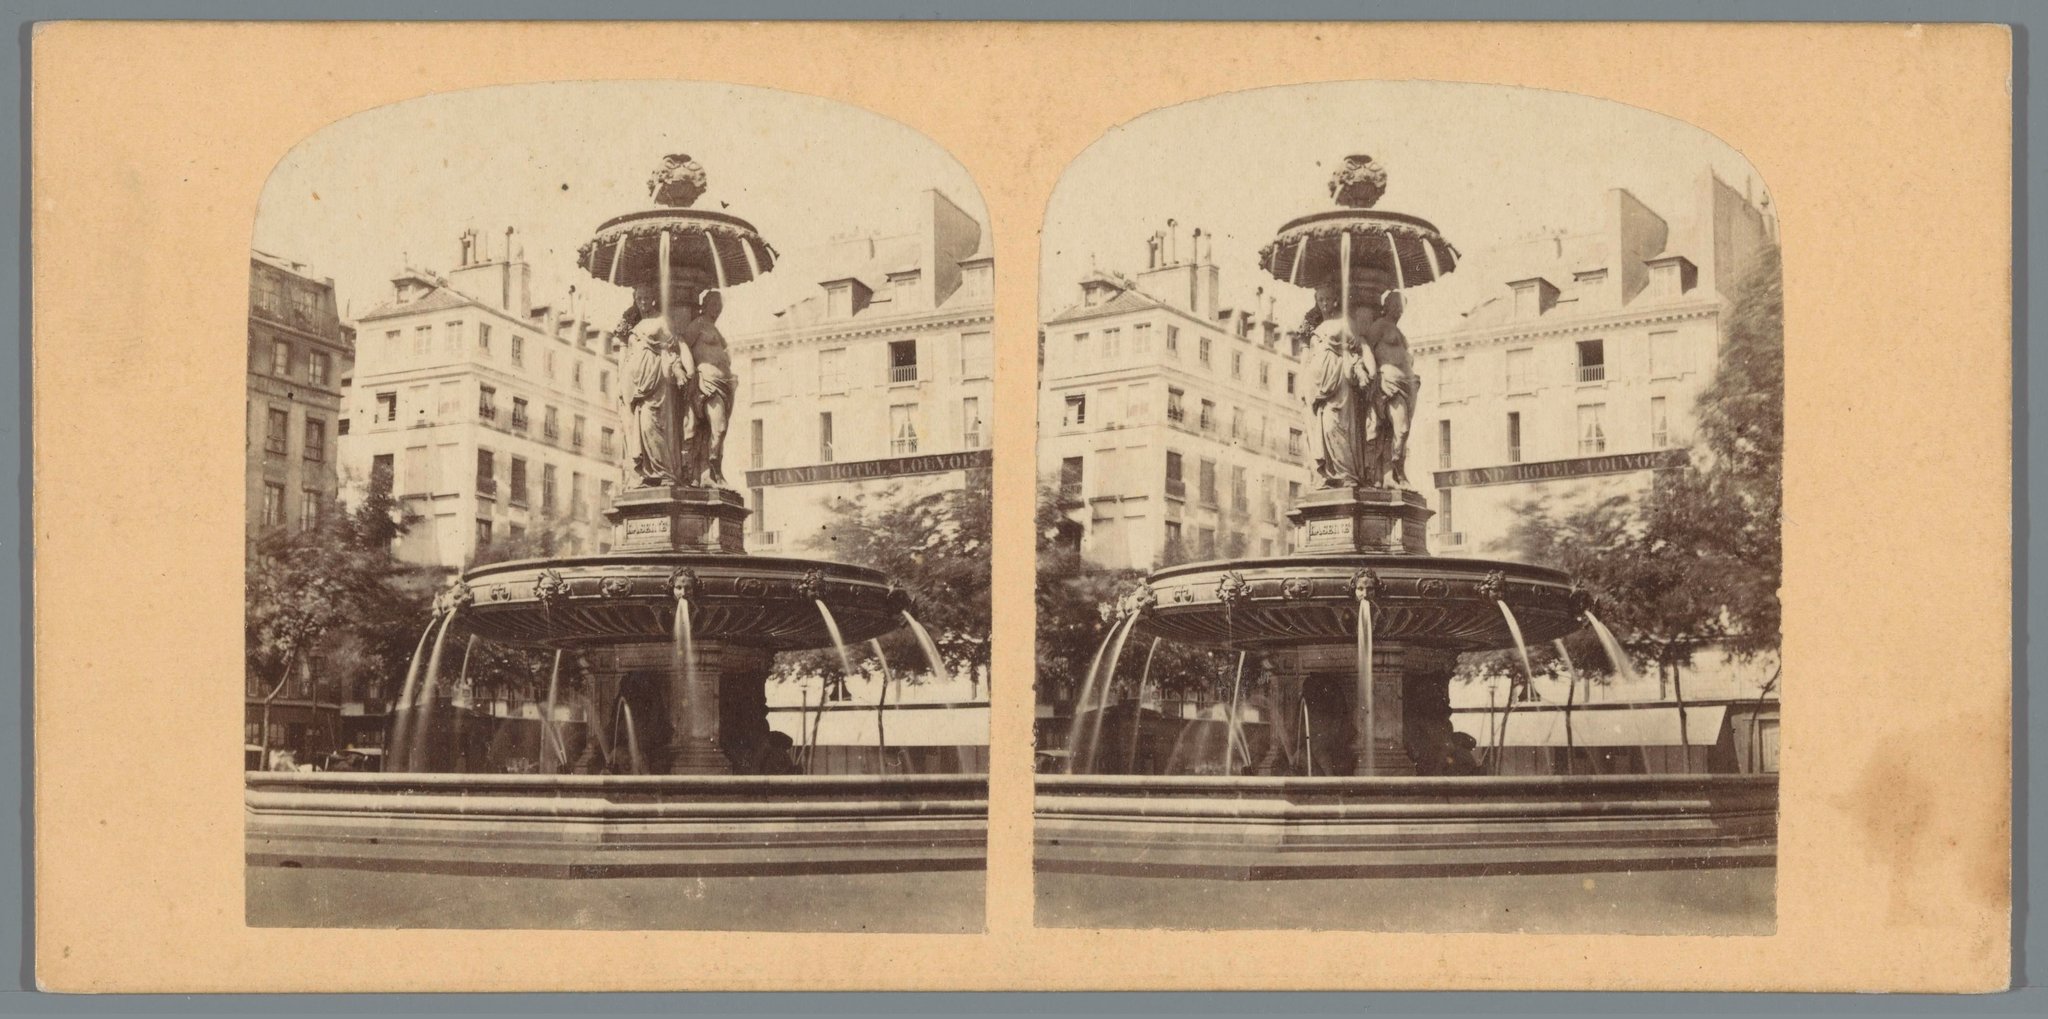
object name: stereograph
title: Gezicht op de Fontaine Louvois in Parijs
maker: Anonymous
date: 1850-1880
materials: cardboard, photographic support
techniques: albumen print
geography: paris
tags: ornamental fountain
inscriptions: inscription: ‘Fontaine Louvois (Paris) 1862 - 1864 - 1867.- 1881 - 1883 - 1887. - 1889. Paris: Square Louvois met Fontein ontworpen door Visconto (1844)’